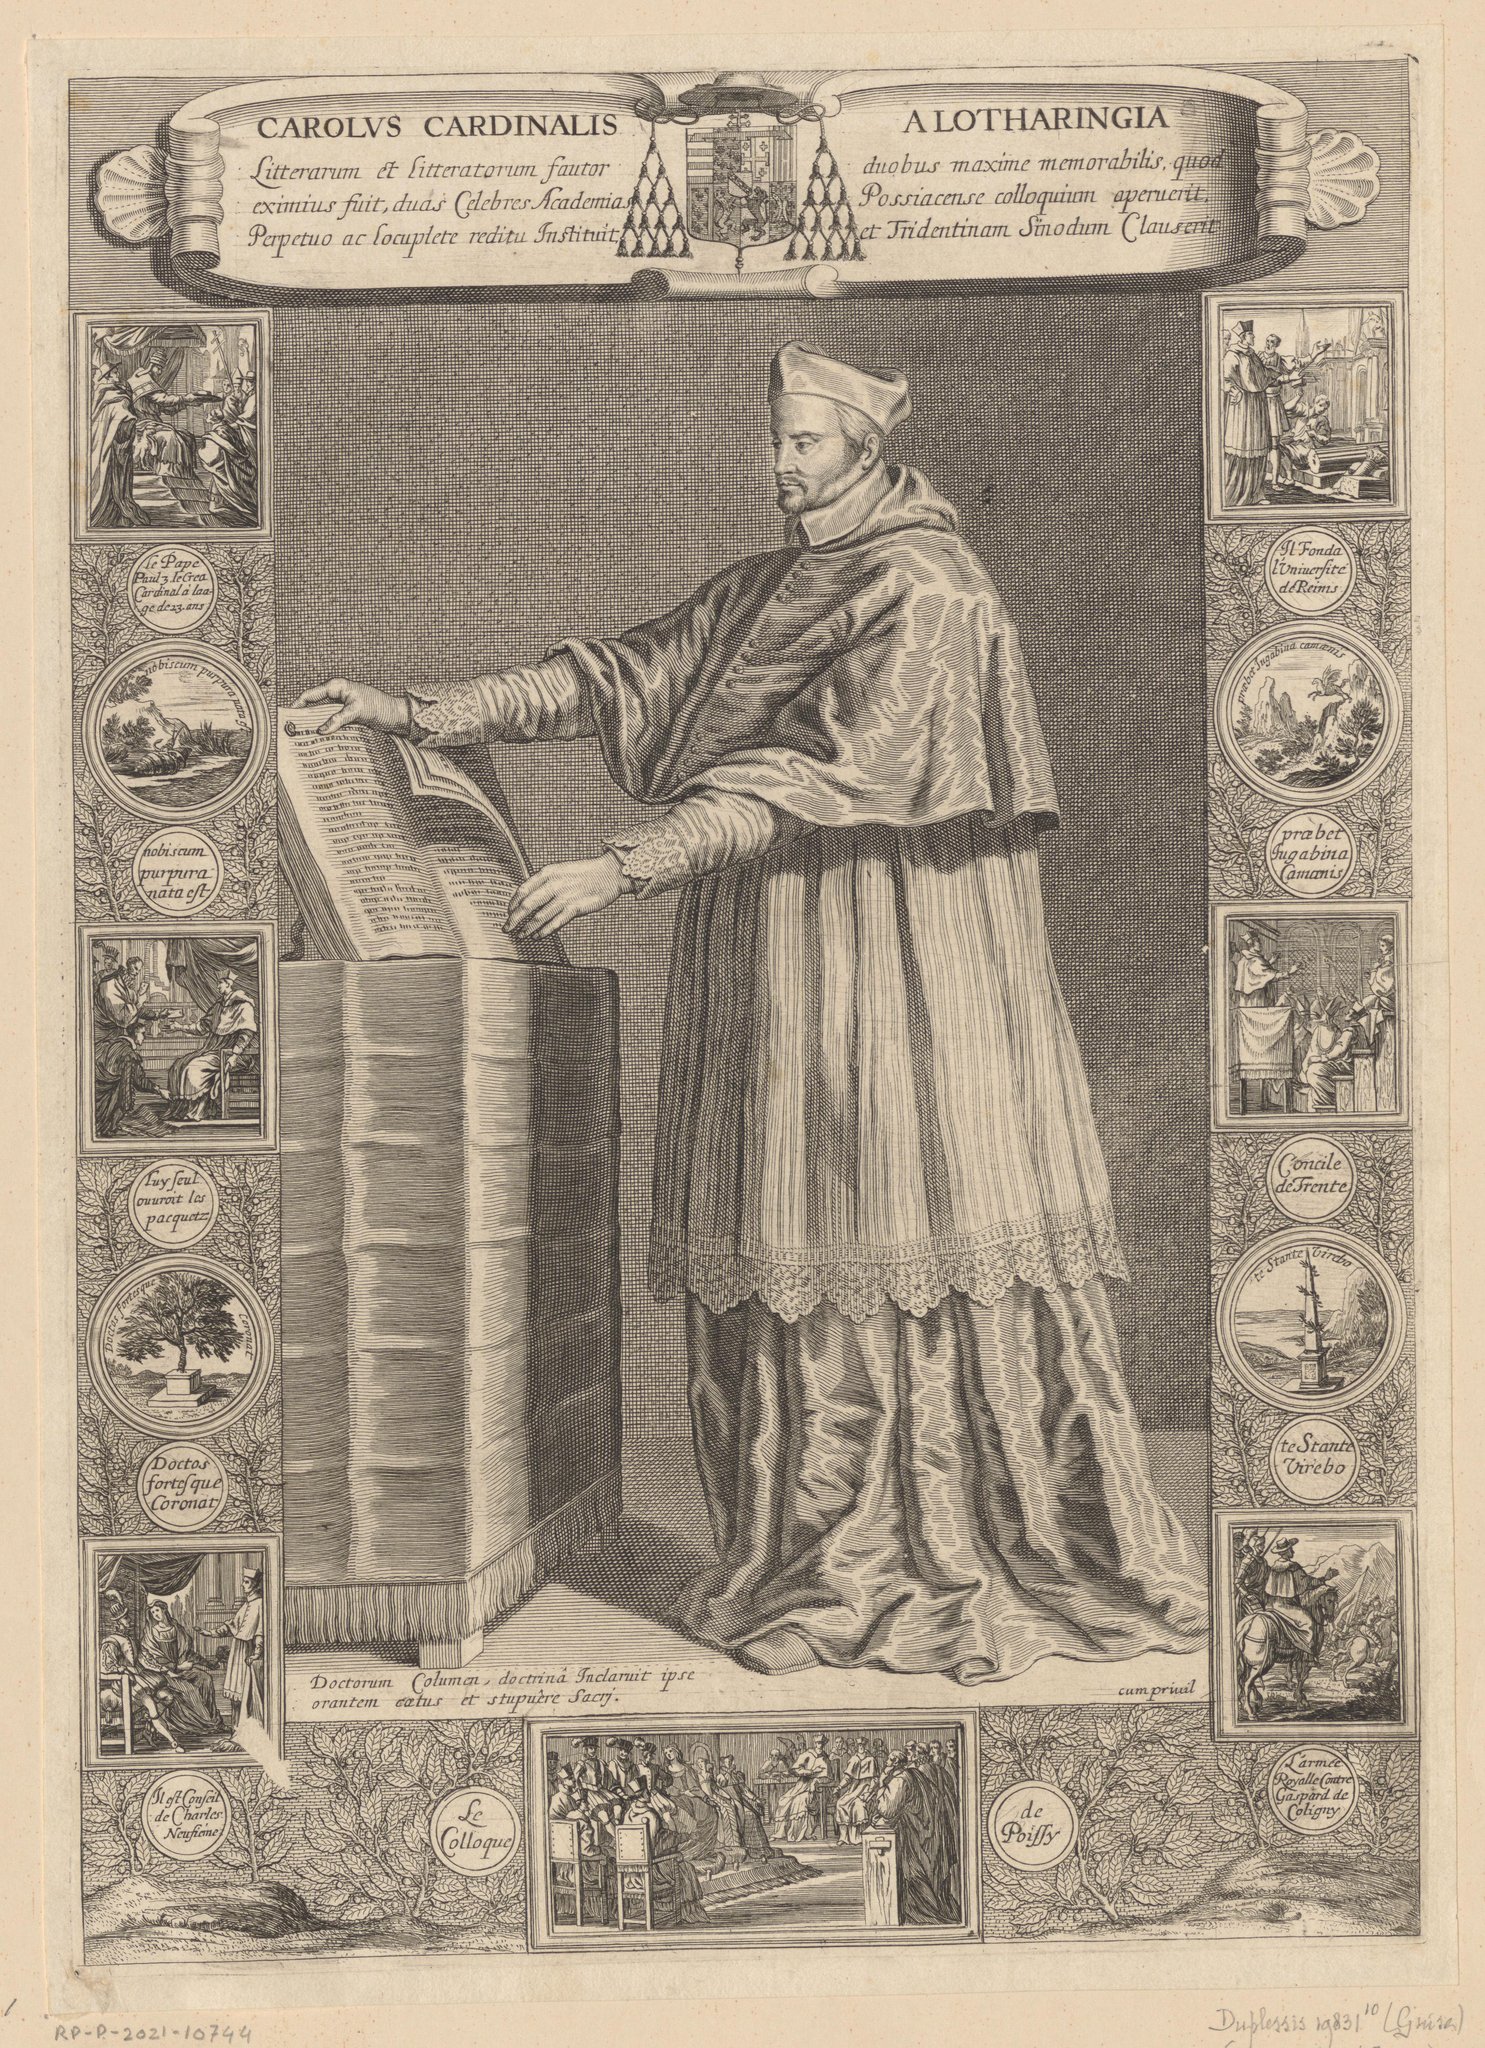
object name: print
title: Portretten uit het paleis van kardinaal de Richelieu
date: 1650-1690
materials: paper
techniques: engraving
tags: standing figure, obelisk, needle, cardinal, historical persons, book - mm - book open, trees: olive-tree, armorial bearing, heraldry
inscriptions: collector's mark: Lugt 2228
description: Prent mogelijk uit: Vulson de La Colombière, Marc de. Les portraits des hommes illustres François qui sont peints dans la gallerie du Palais cardinal de Richelieu (...). Parijs: Henry Sara et al., 1650. Of uit latere publicaties (1655, 1662, 1690 en 1690).